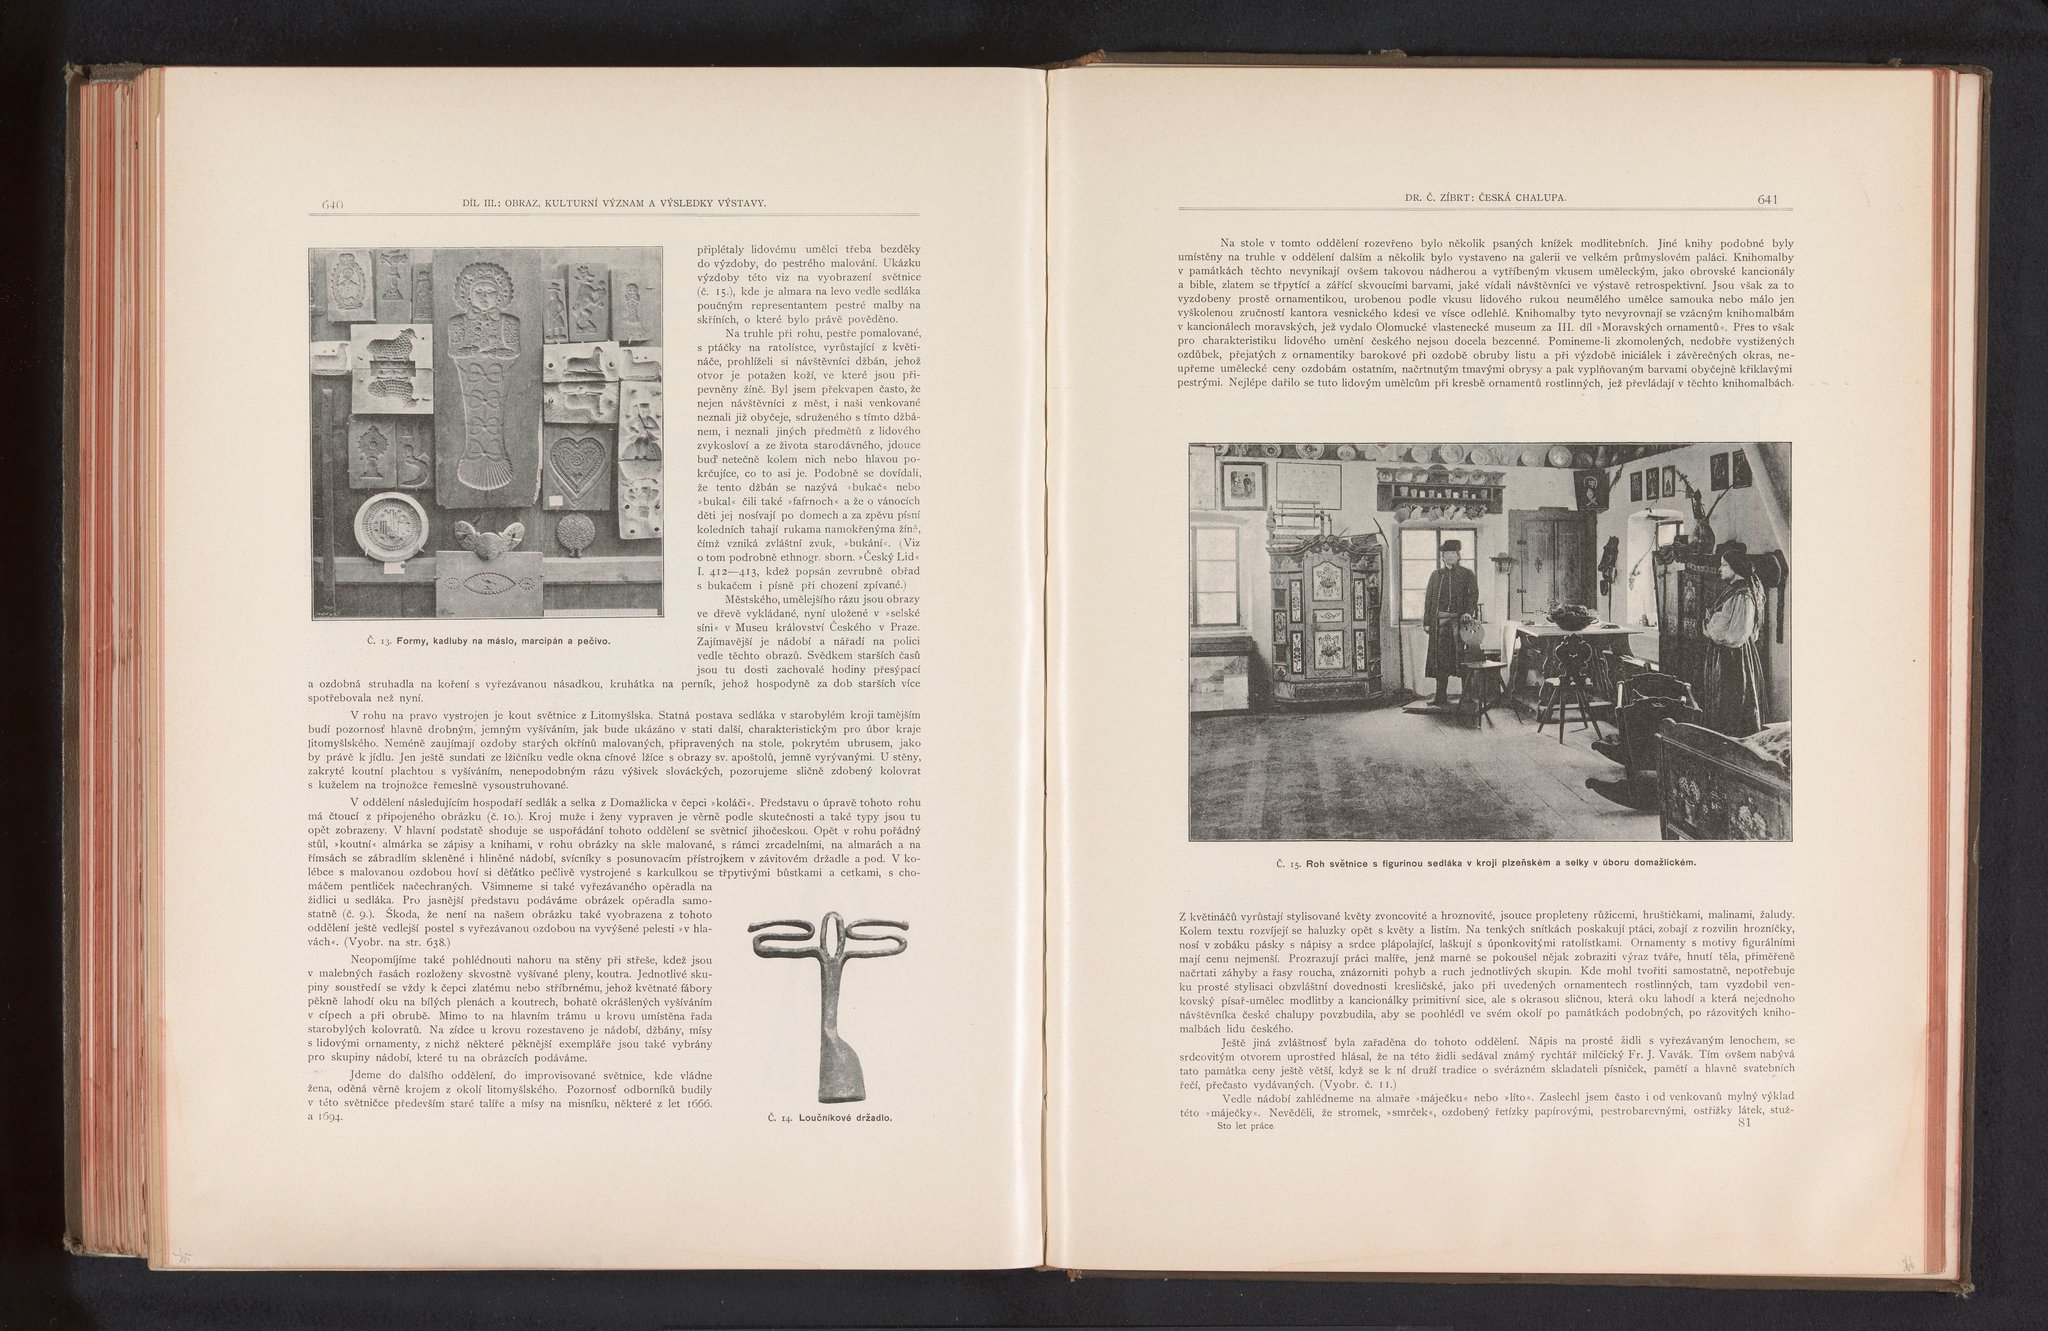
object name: page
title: Formy, kadluby na máslo, marcipan a pecivo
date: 1891-1895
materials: paper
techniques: autotype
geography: prague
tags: door-handle, doorknob, baker's moulds